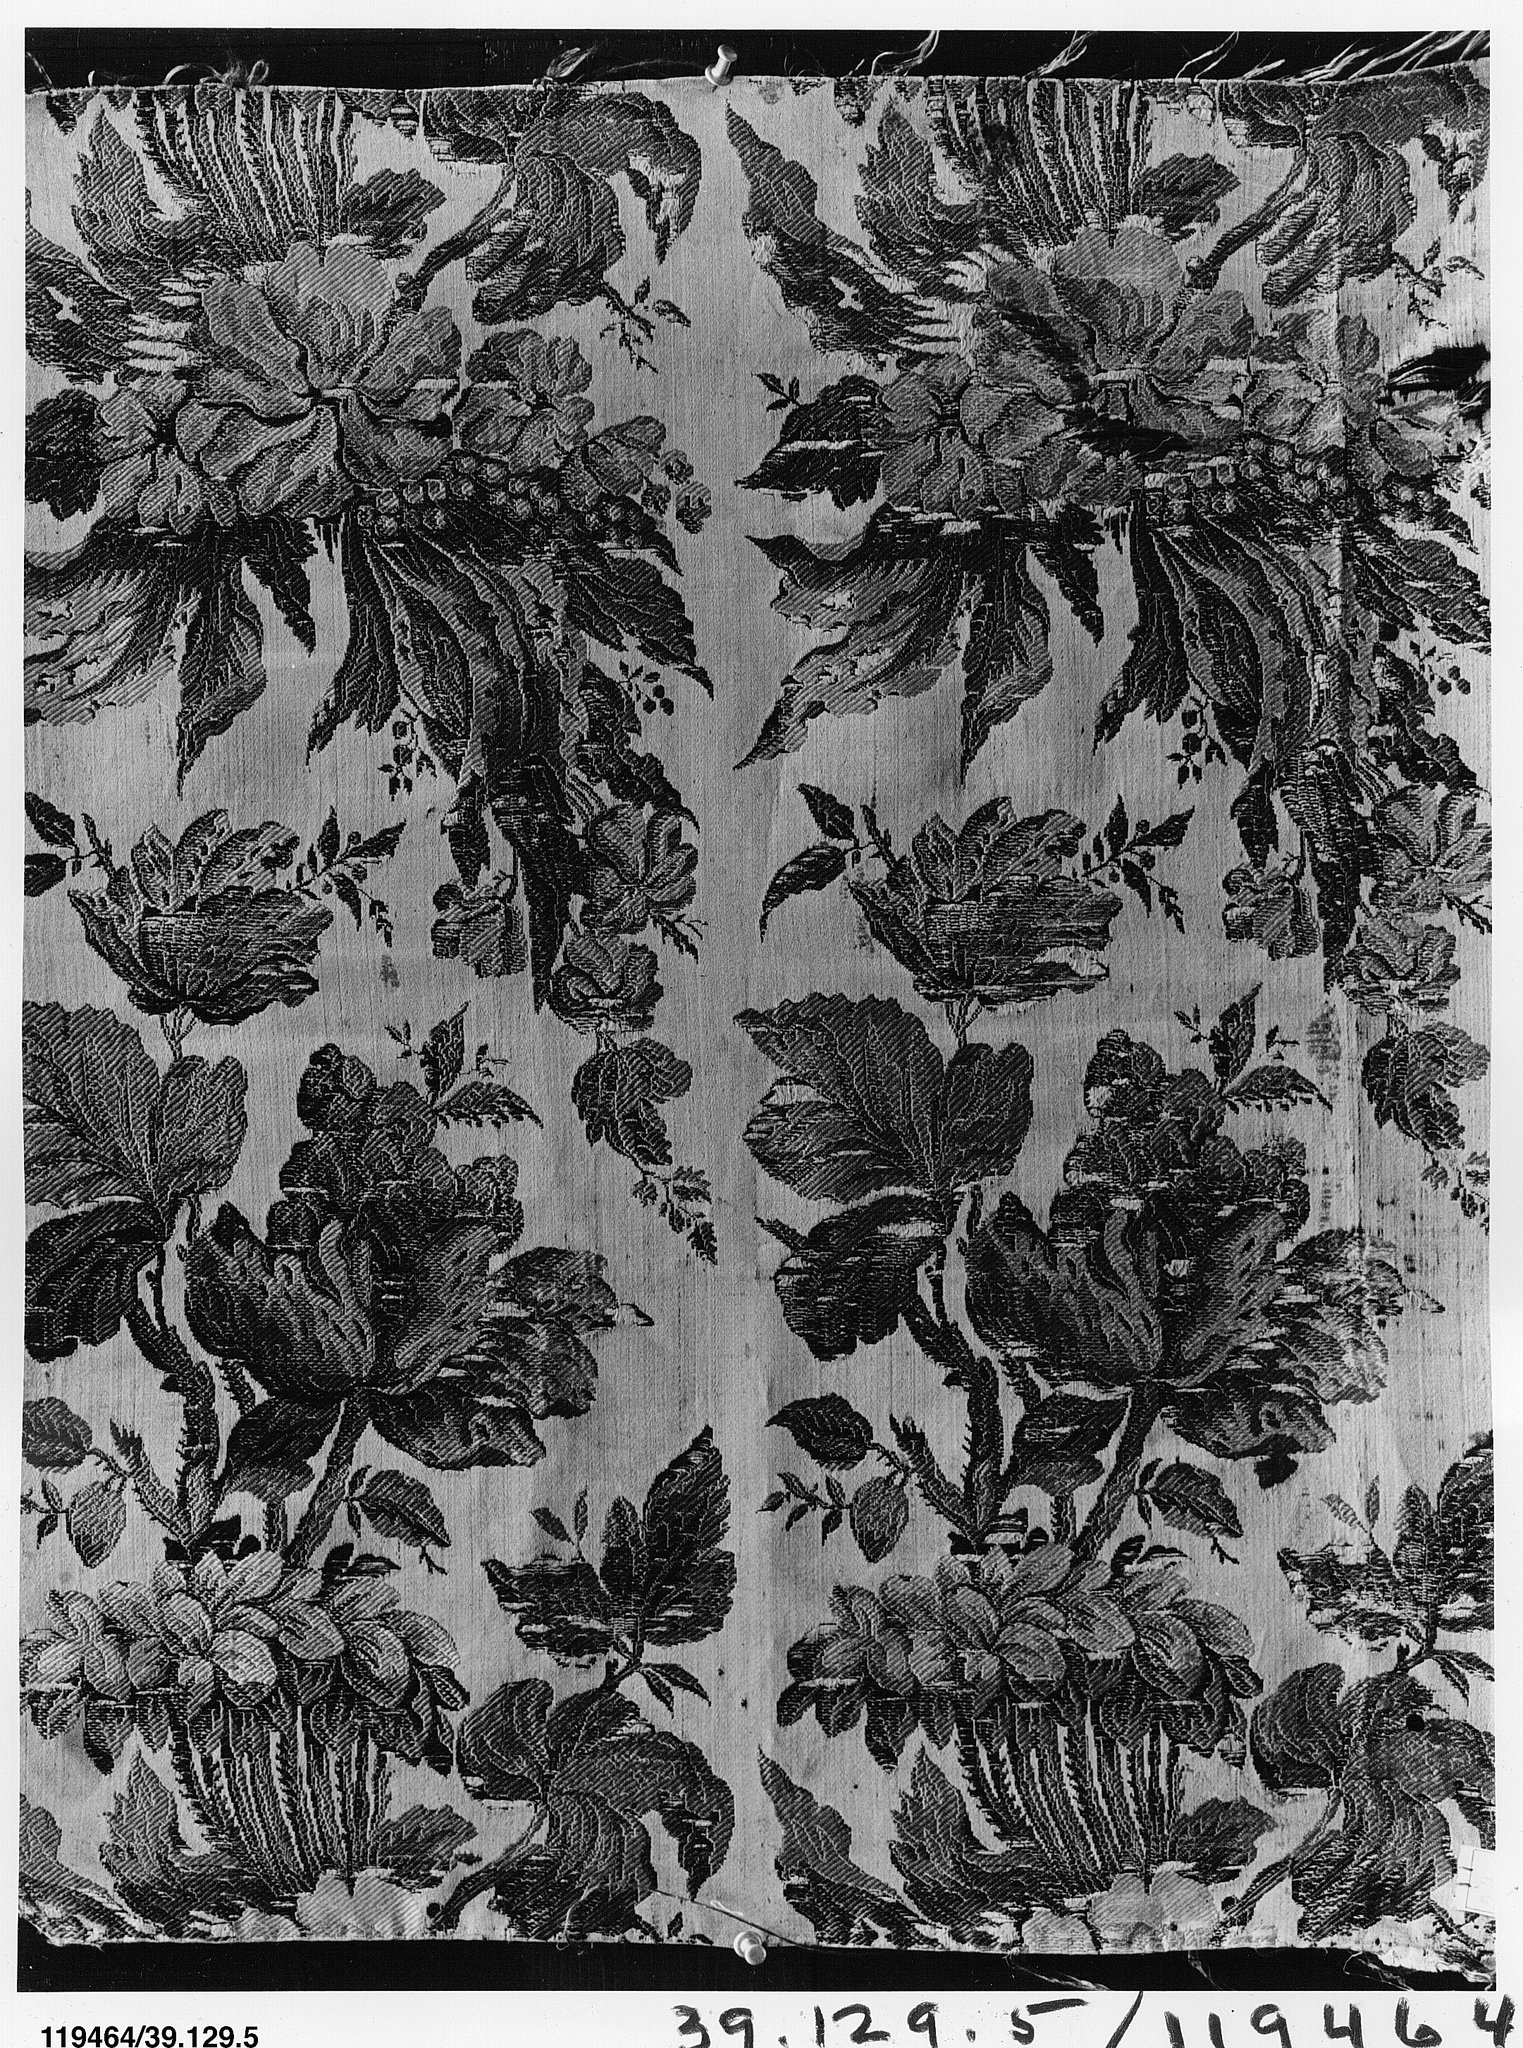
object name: piece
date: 1730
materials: silk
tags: flowers,leaves